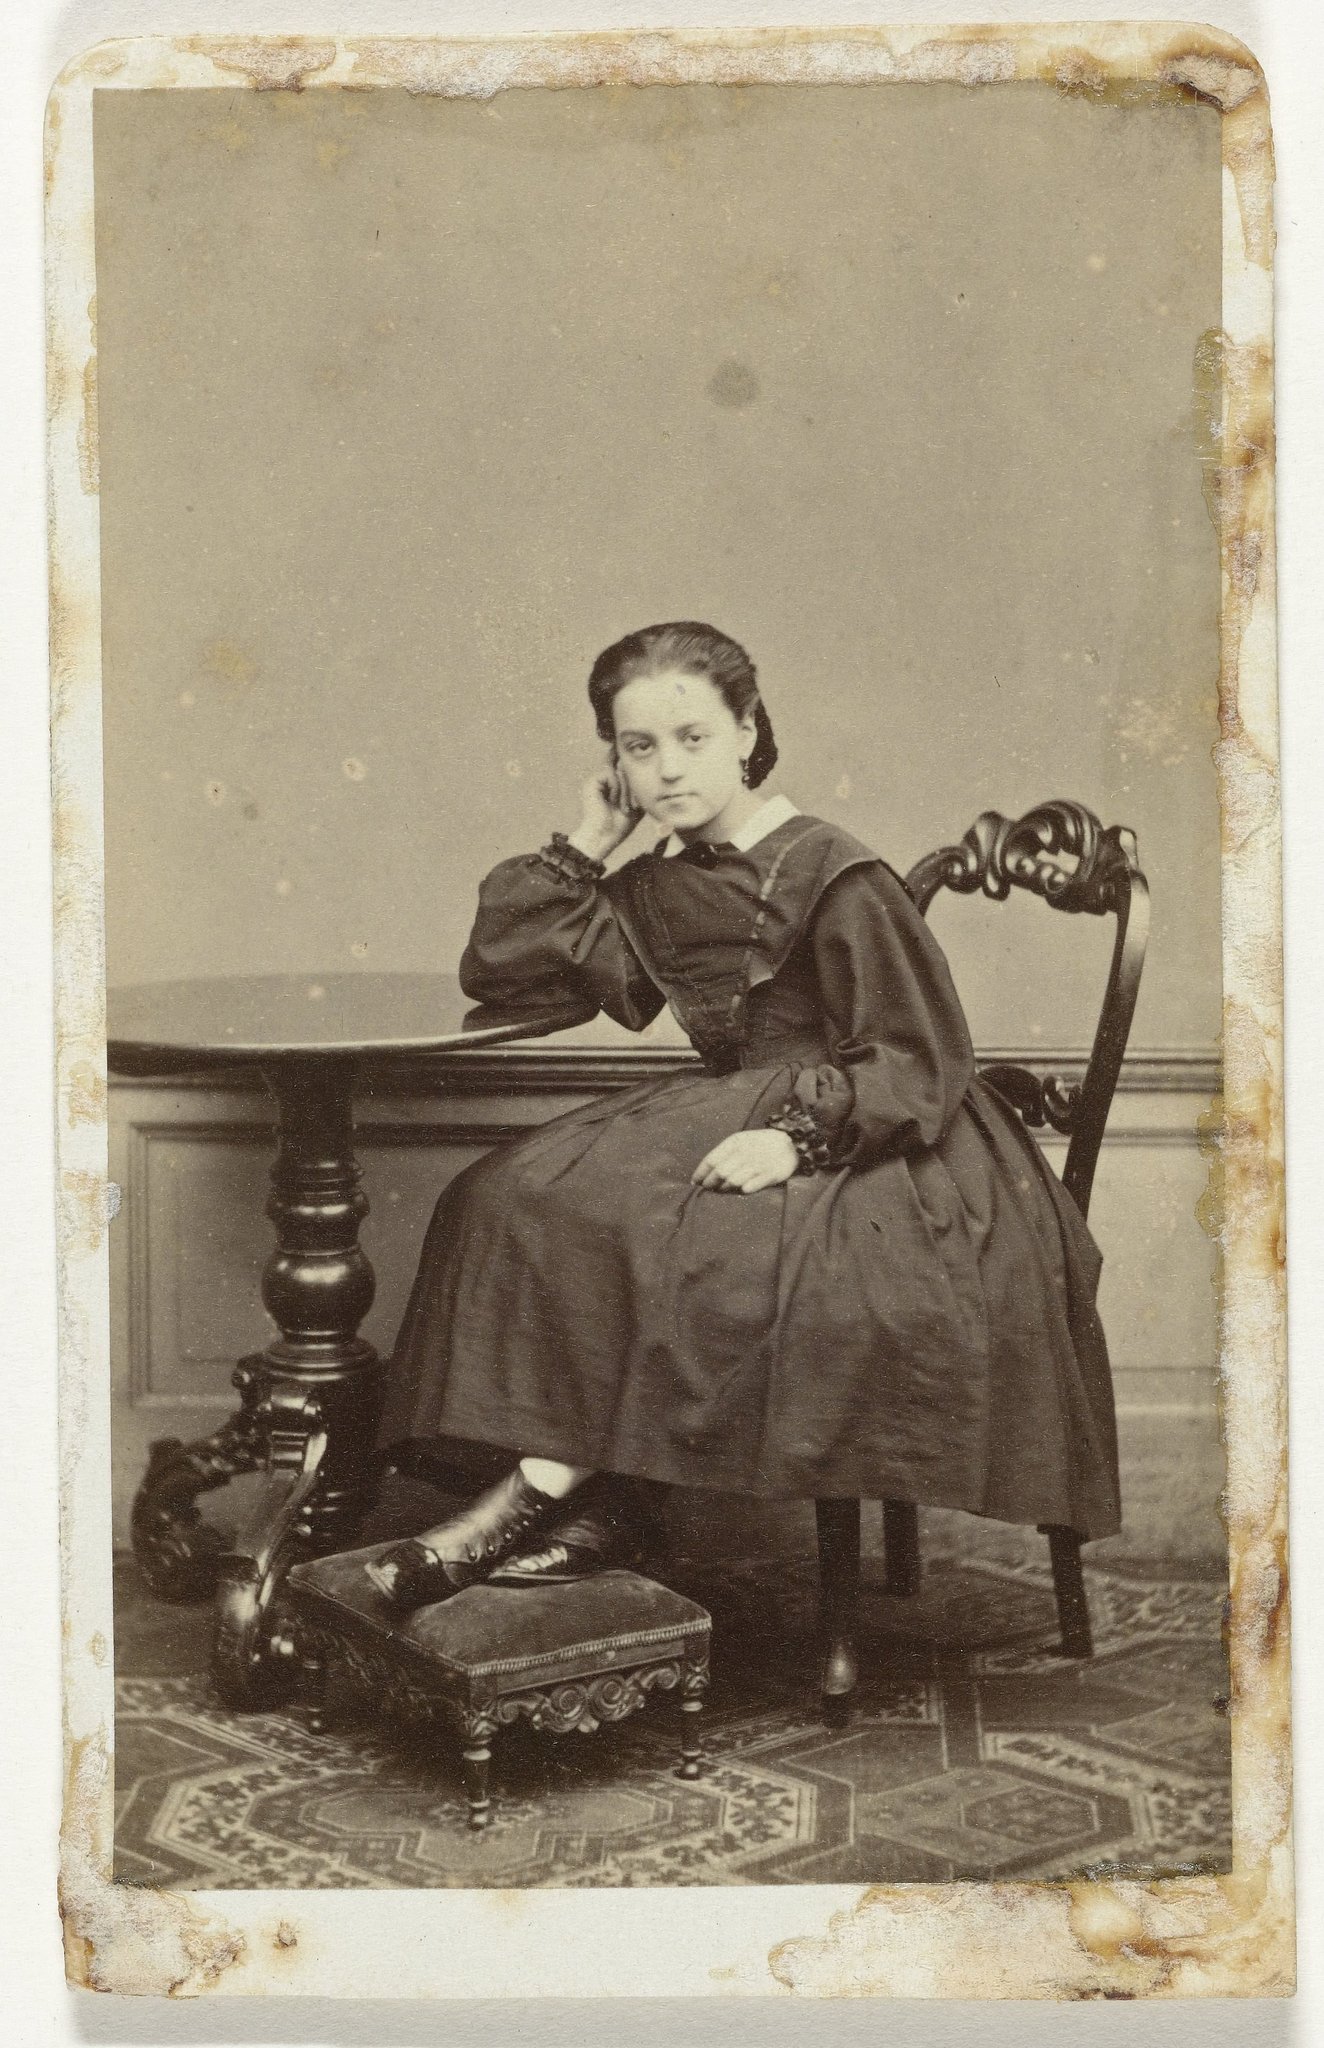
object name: carte de visite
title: Portret van een jong meisje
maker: gerrit hoogwinkel jr.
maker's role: fotograaf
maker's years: 1837-1890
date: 1863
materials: cardboard, paper, photographic support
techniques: albumen print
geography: rotterdam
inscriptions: signature and address: ‘G. Hoogwinkel/Photographe/Rotterdam’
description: Jong meisje in donkere japon, zittend aan kleine ronde tafel met de voeten op een voetenbankje